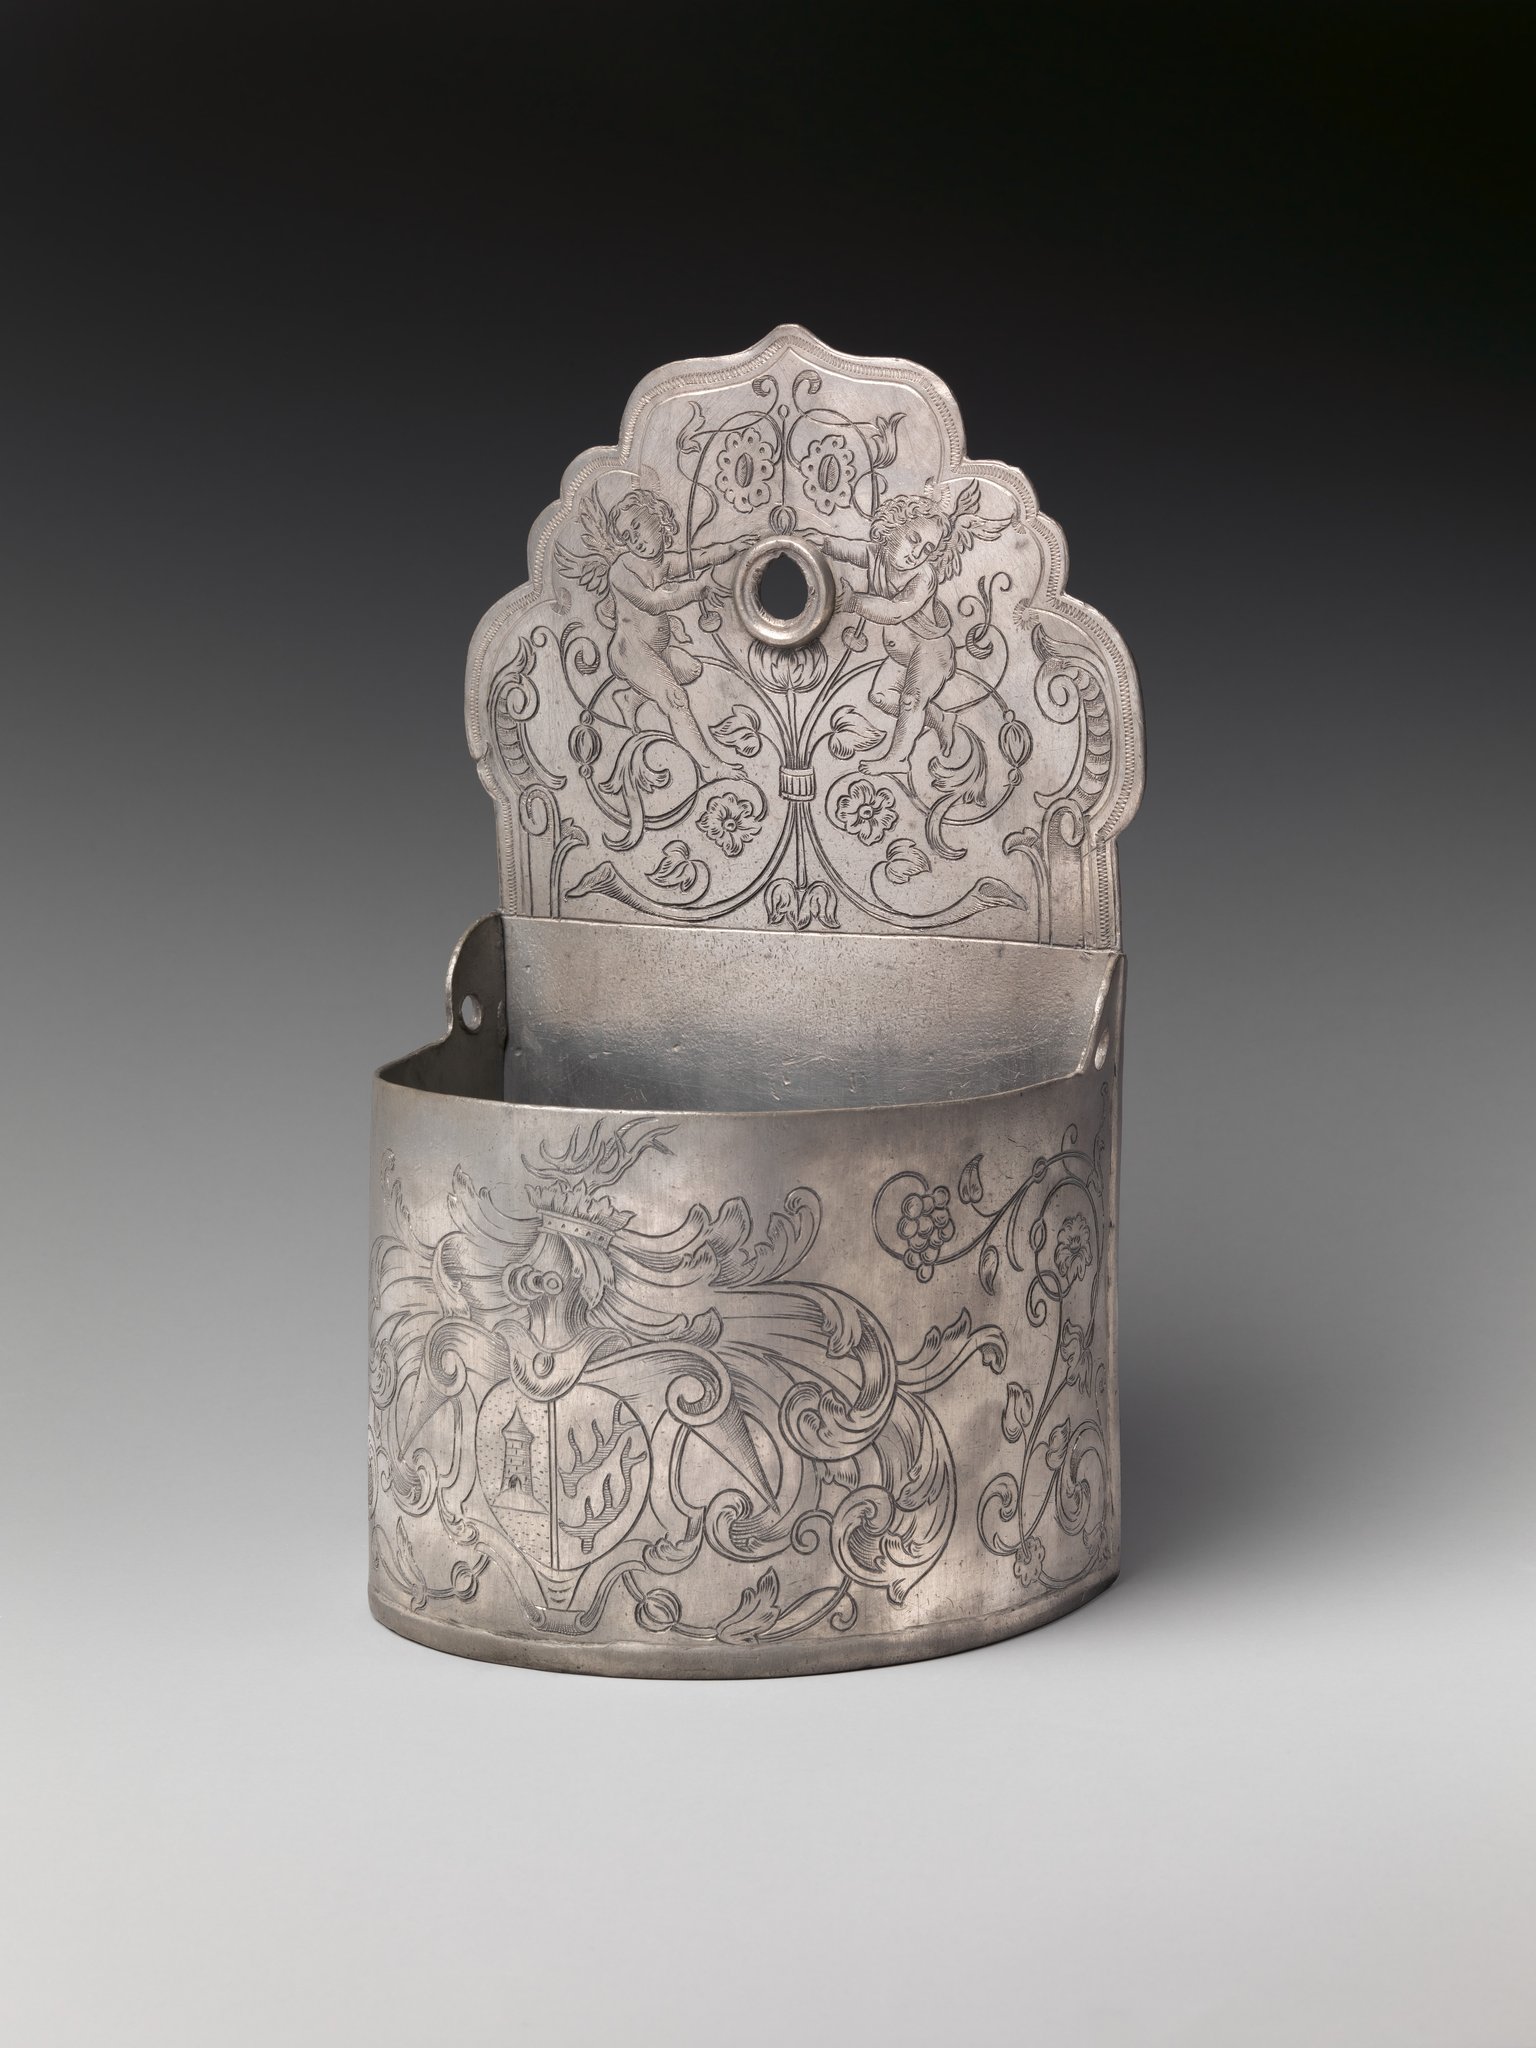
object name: salt box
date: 1567-1600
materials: pewter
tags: putti,coat of arms